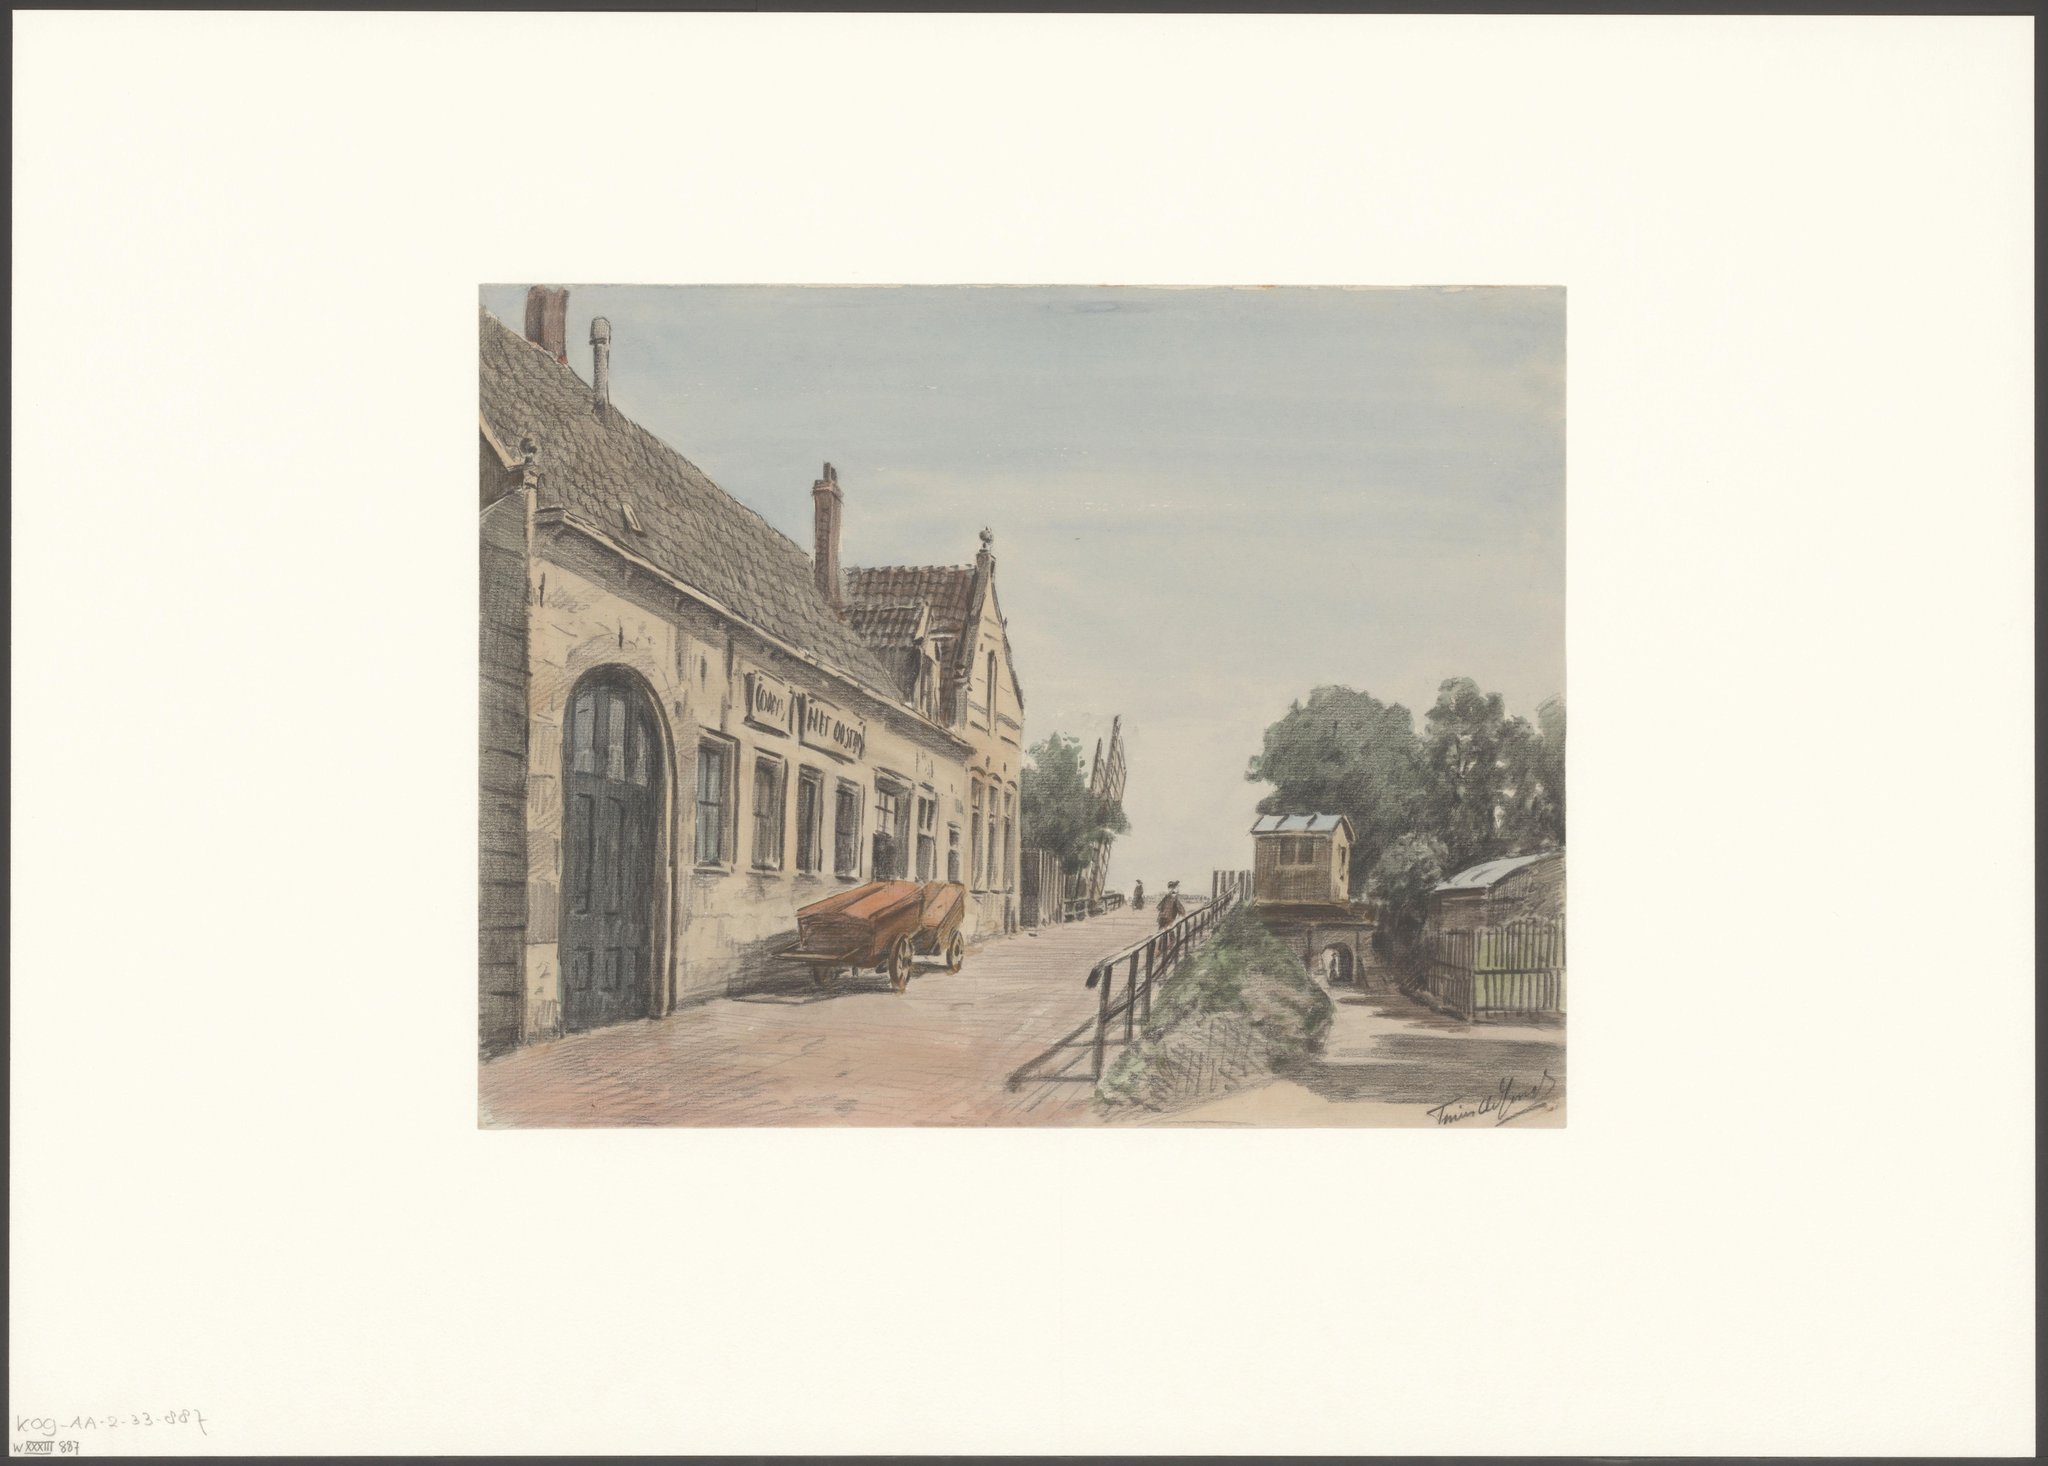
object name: drawing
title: Gezicht op de spoorwegovergang bij de Weesperzijde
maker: tinus de jongh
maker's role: print maker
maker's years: 1885-1942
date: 1906-1919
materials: chalk, gouache, paper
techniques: brush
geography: amsterdam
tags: city-view in general; 'veduta', railway, train, street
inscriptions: inscription: ‘oprit van de (...) geheel rechts karpe[...]fah.’, signature: ‘TinusdeJongh’, collector's mark: Lugt 800a, signature and date: ‘Juni / 1919 / TinusdeJongh’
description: Tekening binnen de Atlas Van Eck ingedeeld op wijknummer 33.